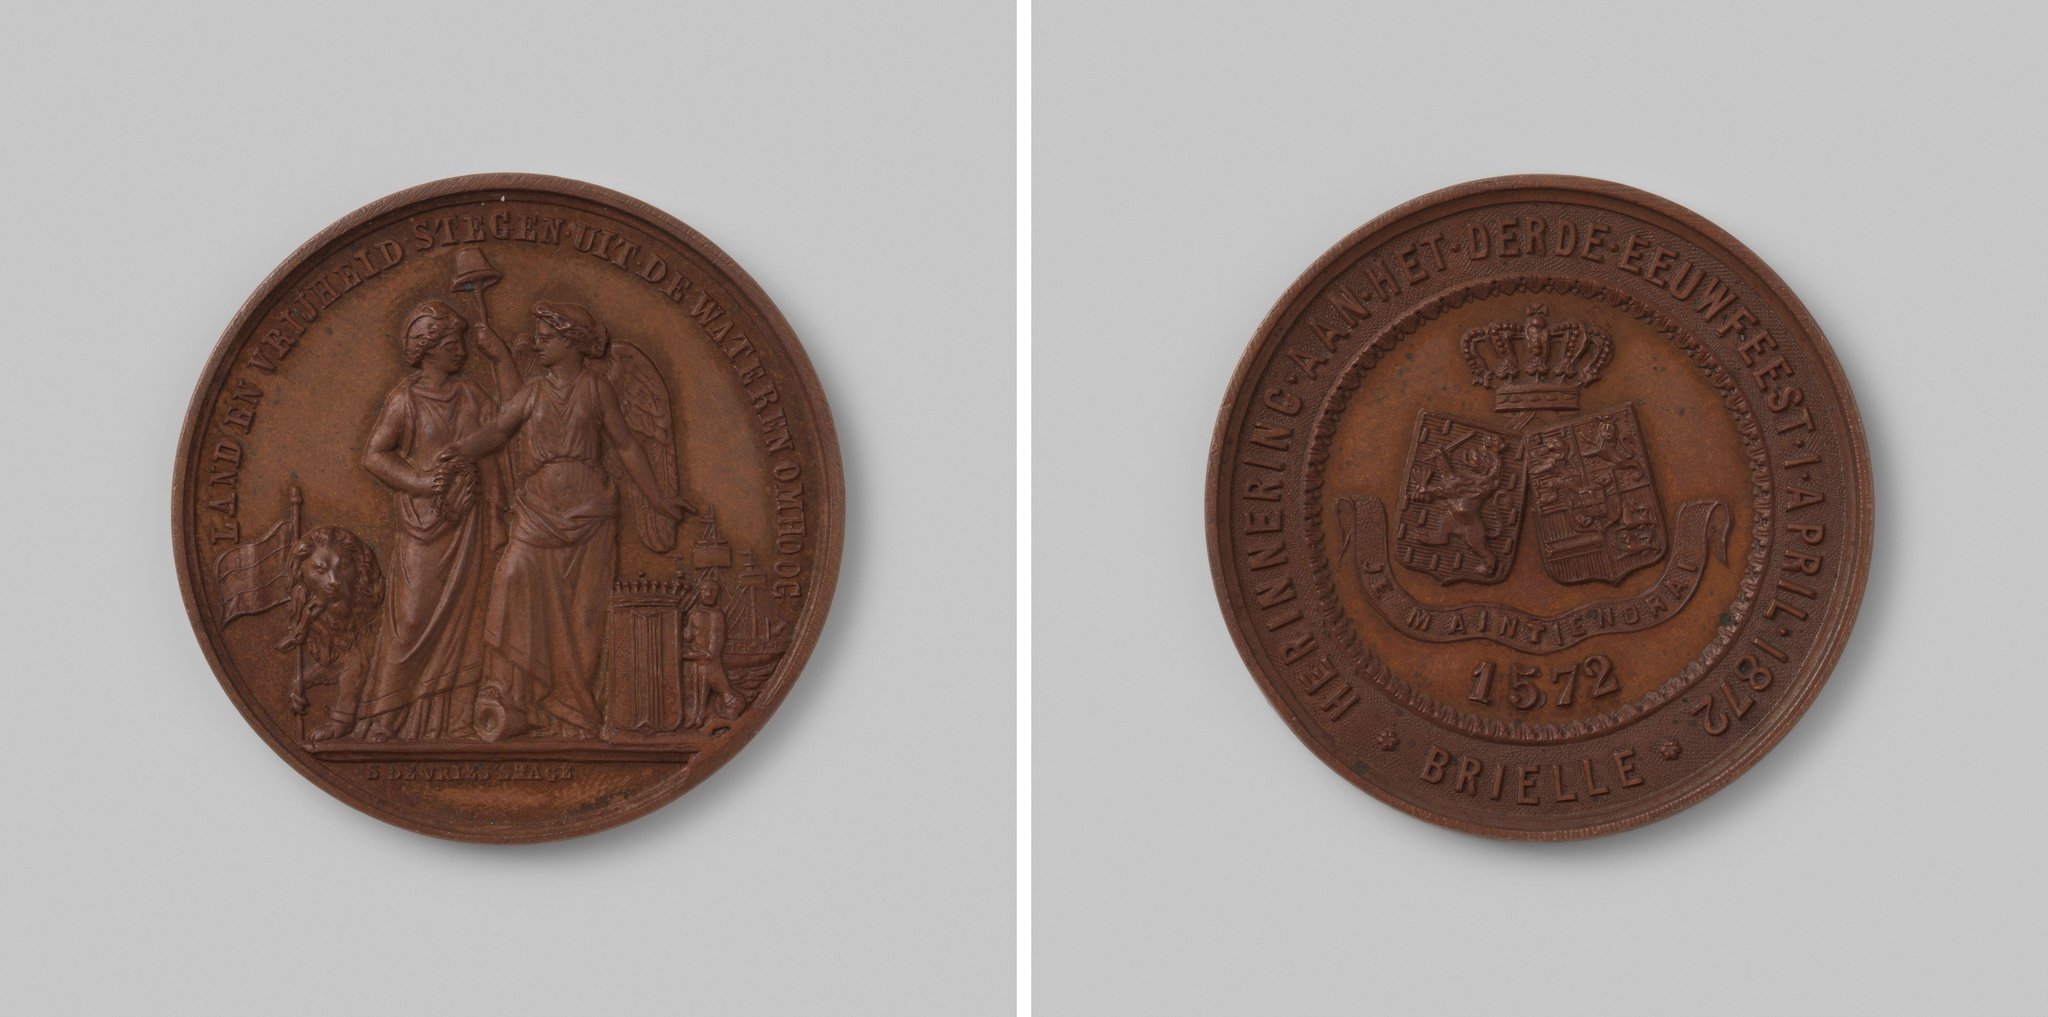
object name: history medal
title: Derde eeuwfeest van de inname van Den Briel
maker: salomon de vries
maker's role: graveur, medailleur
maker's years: 1830-1899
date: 1872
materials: bronze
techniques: striking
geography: the hague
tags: brielle